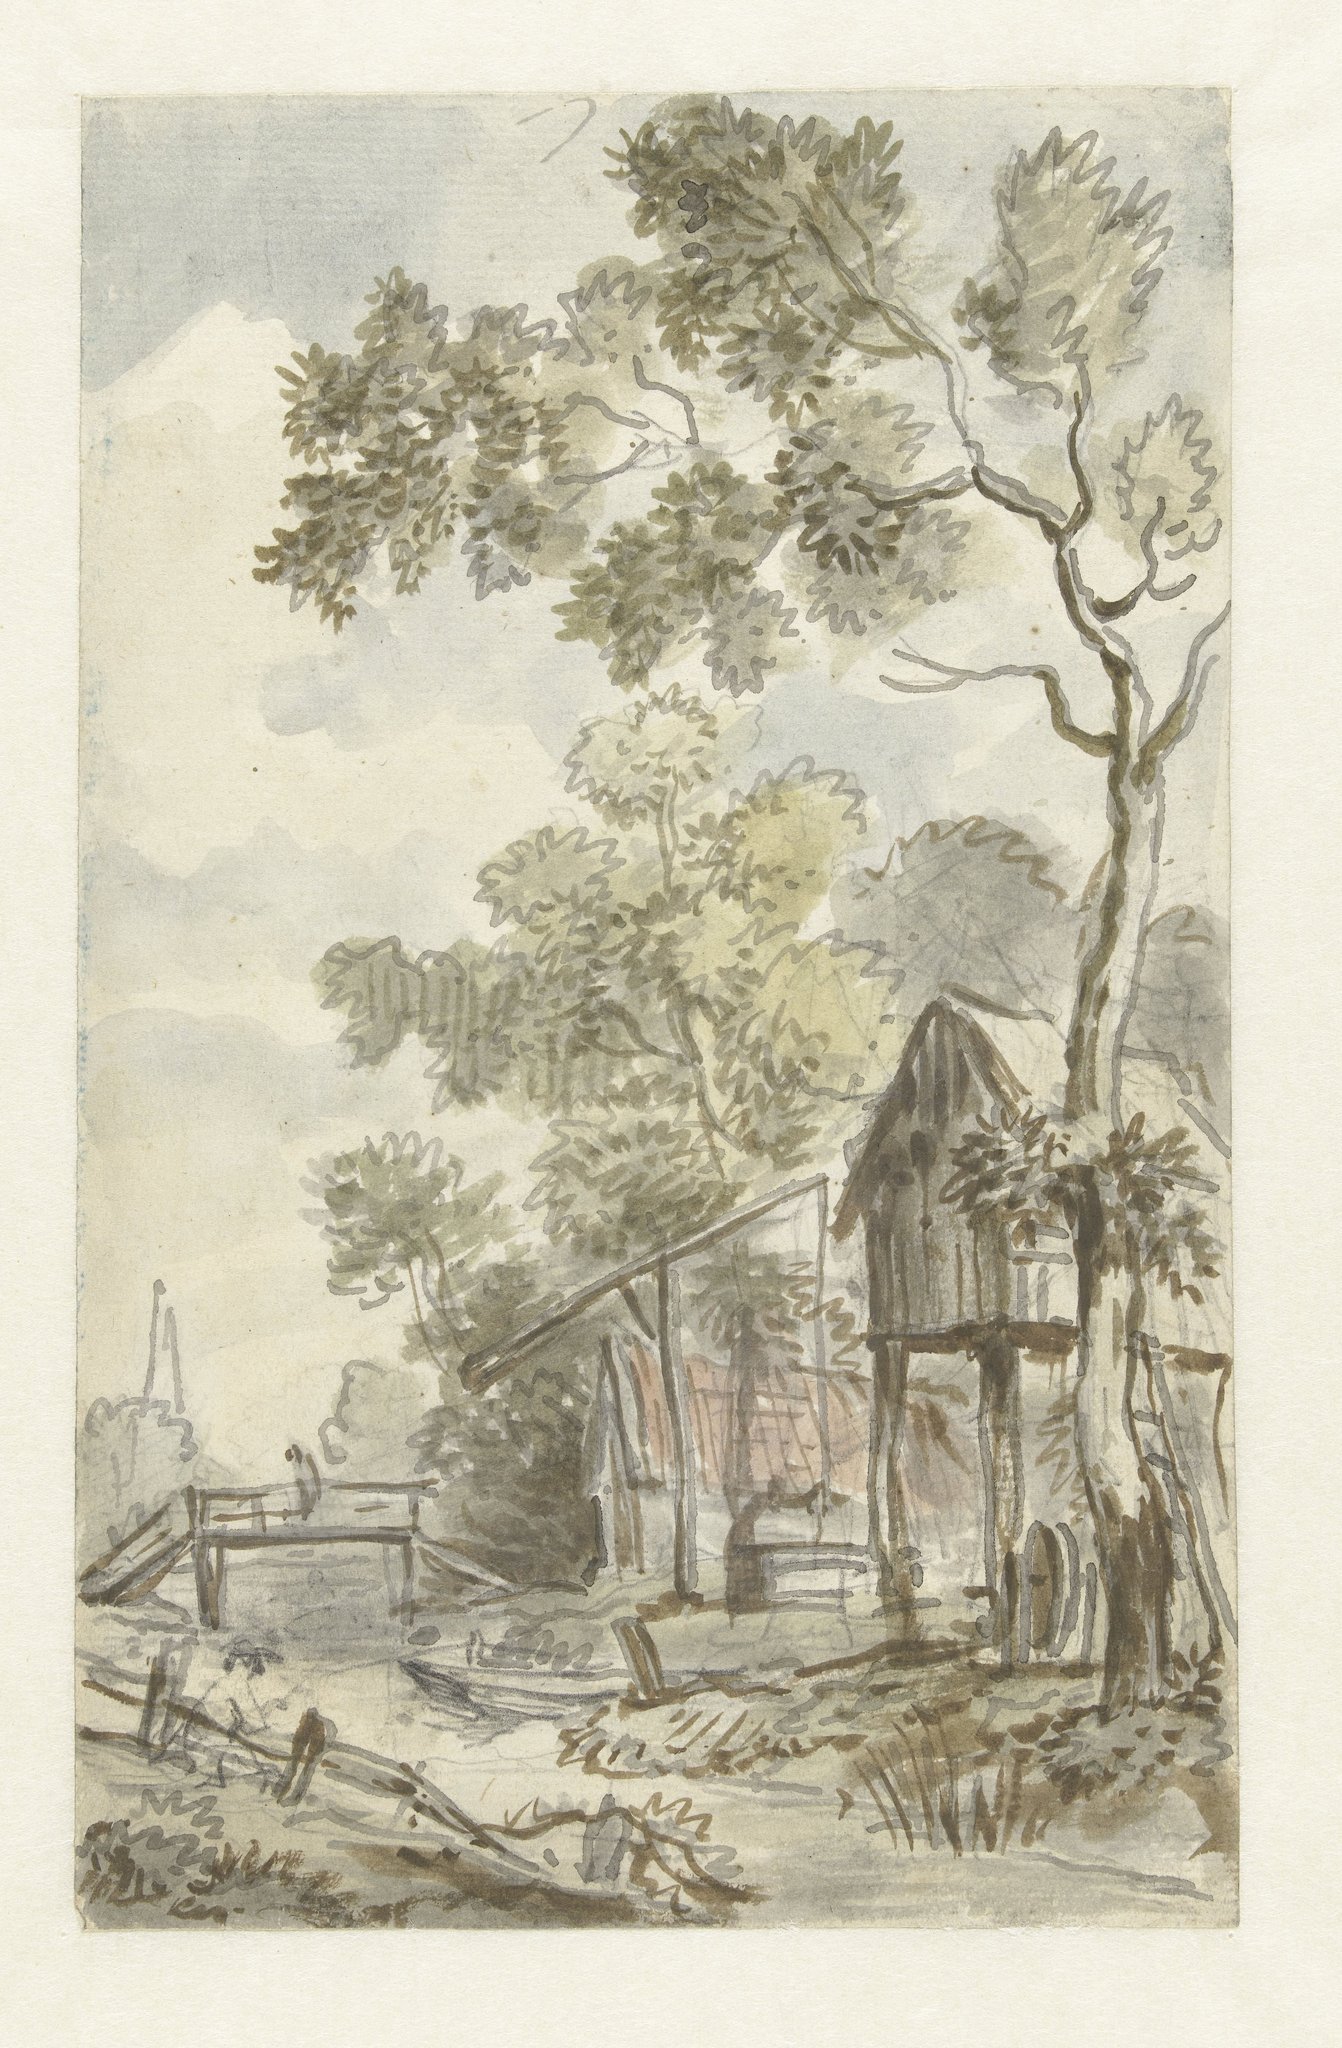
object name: design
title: Ontwerp voor behangselschildering met Hollands landschap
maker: jurriaan andriessen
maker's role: draughtsman, painter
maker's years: 1742-1819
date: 1752-1819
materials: graphite, ink, paper, watercolor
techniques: brush, pen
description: Ontwerp voor behangselschildering: Hollands landschap.